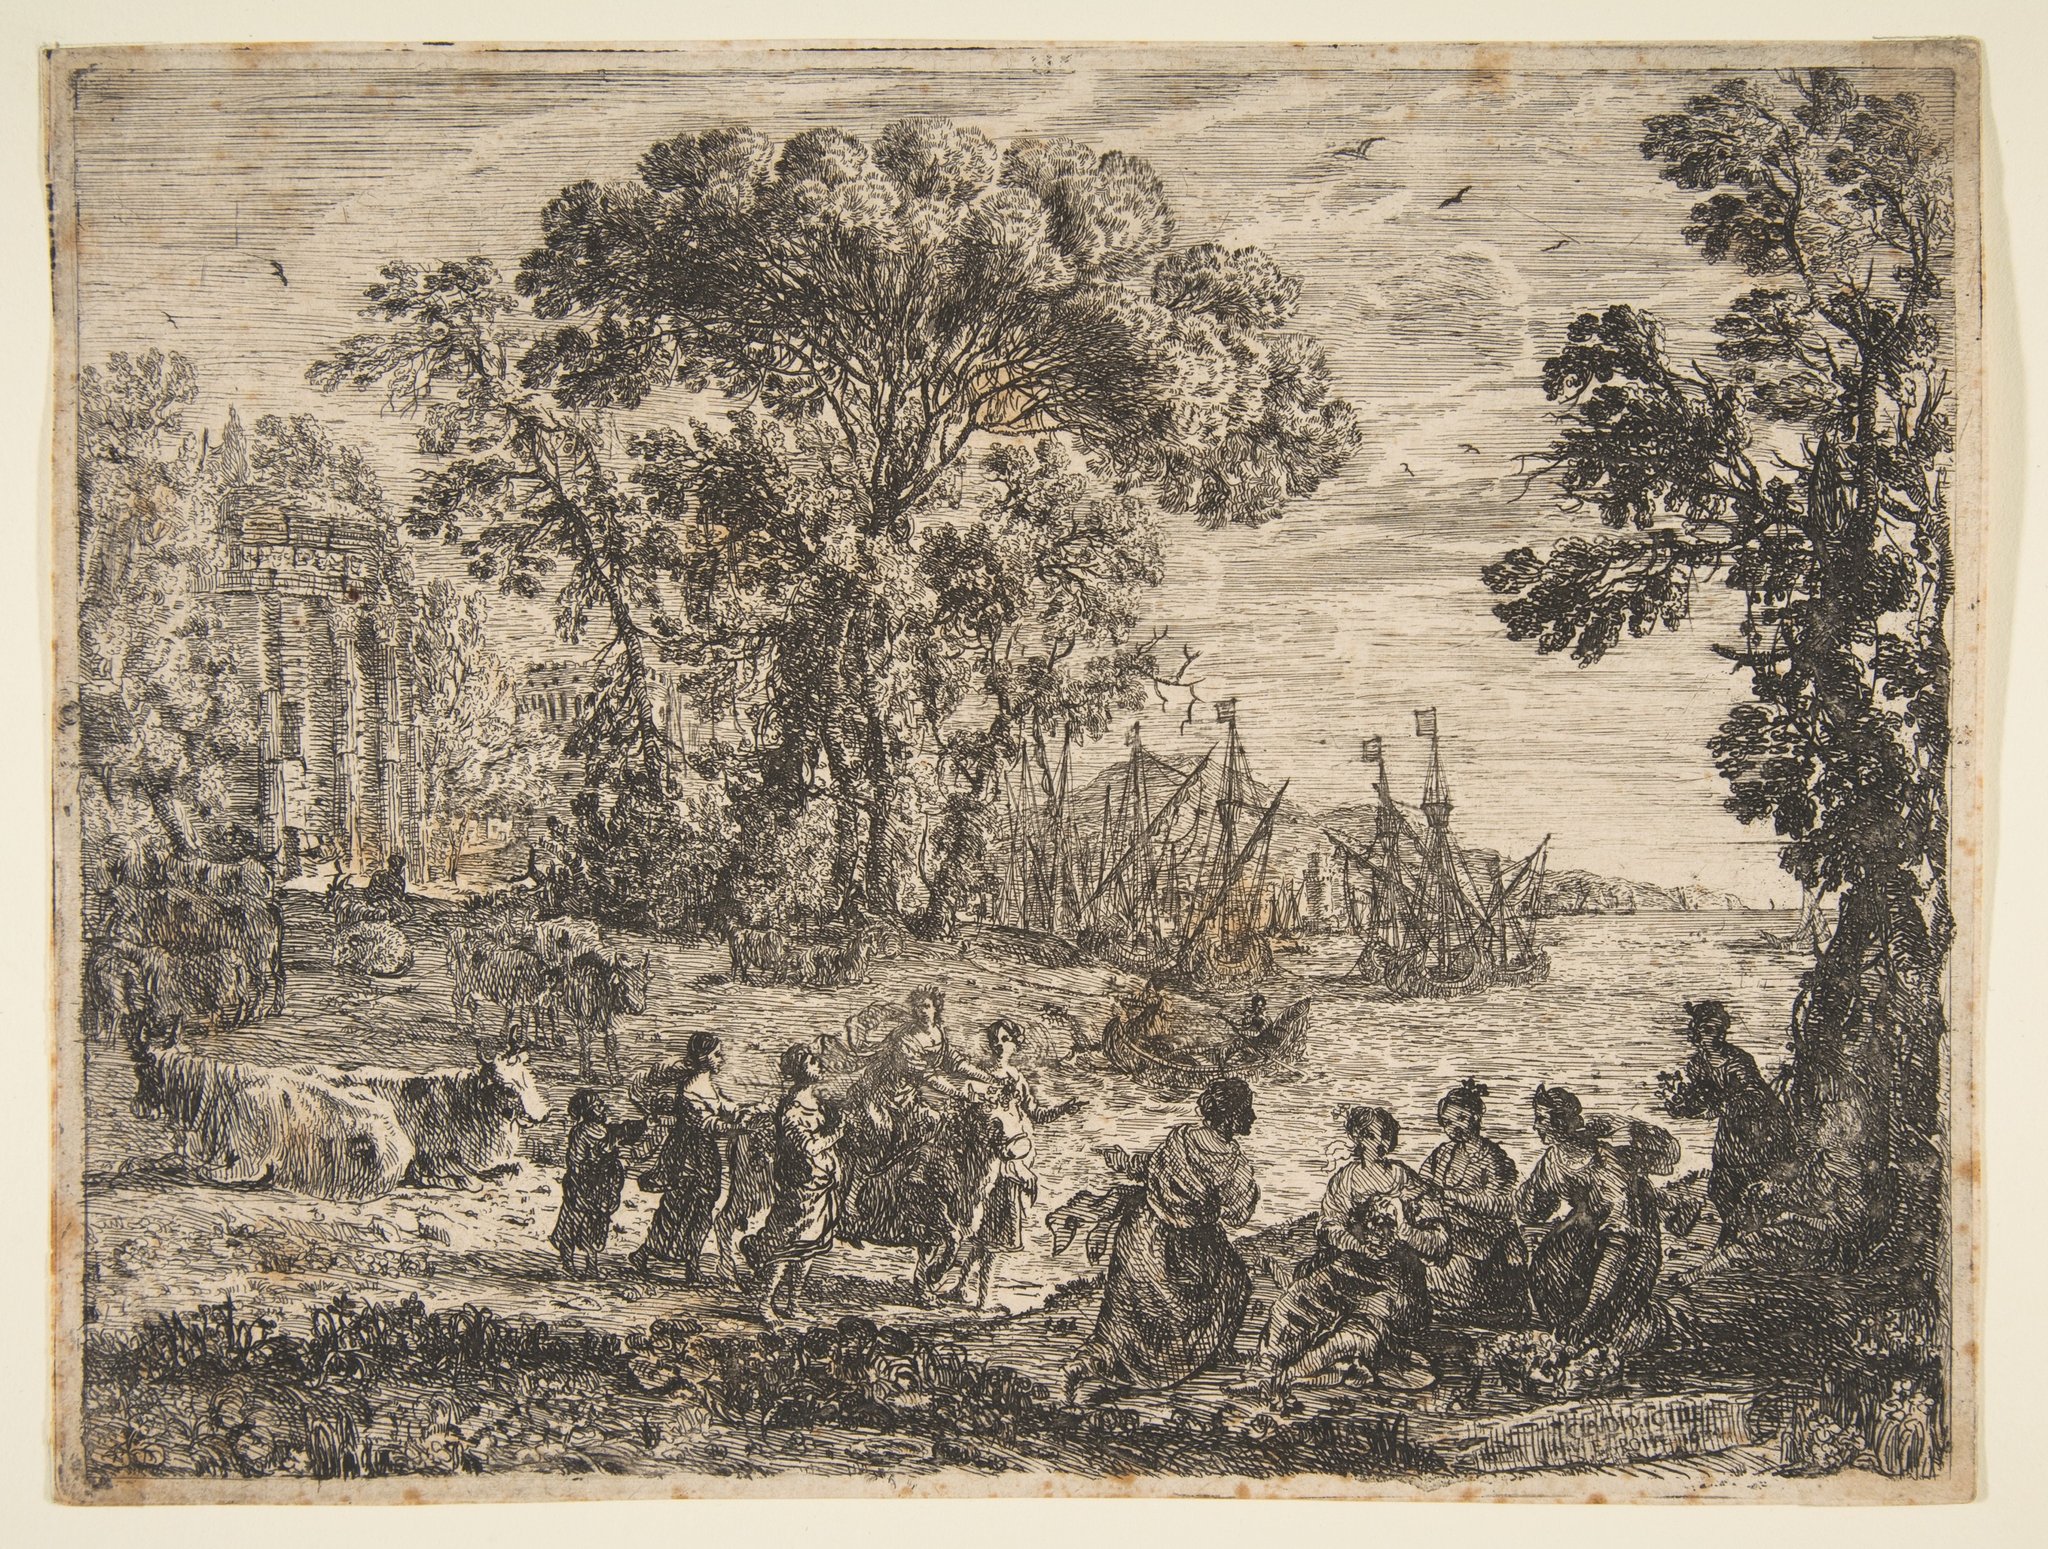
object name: print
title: The Rape of Europa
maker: claude lorrain (claude gellée)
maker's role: artist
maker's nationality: french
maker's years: 1604-1682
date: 1634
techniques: etching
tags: women,bulls,ships